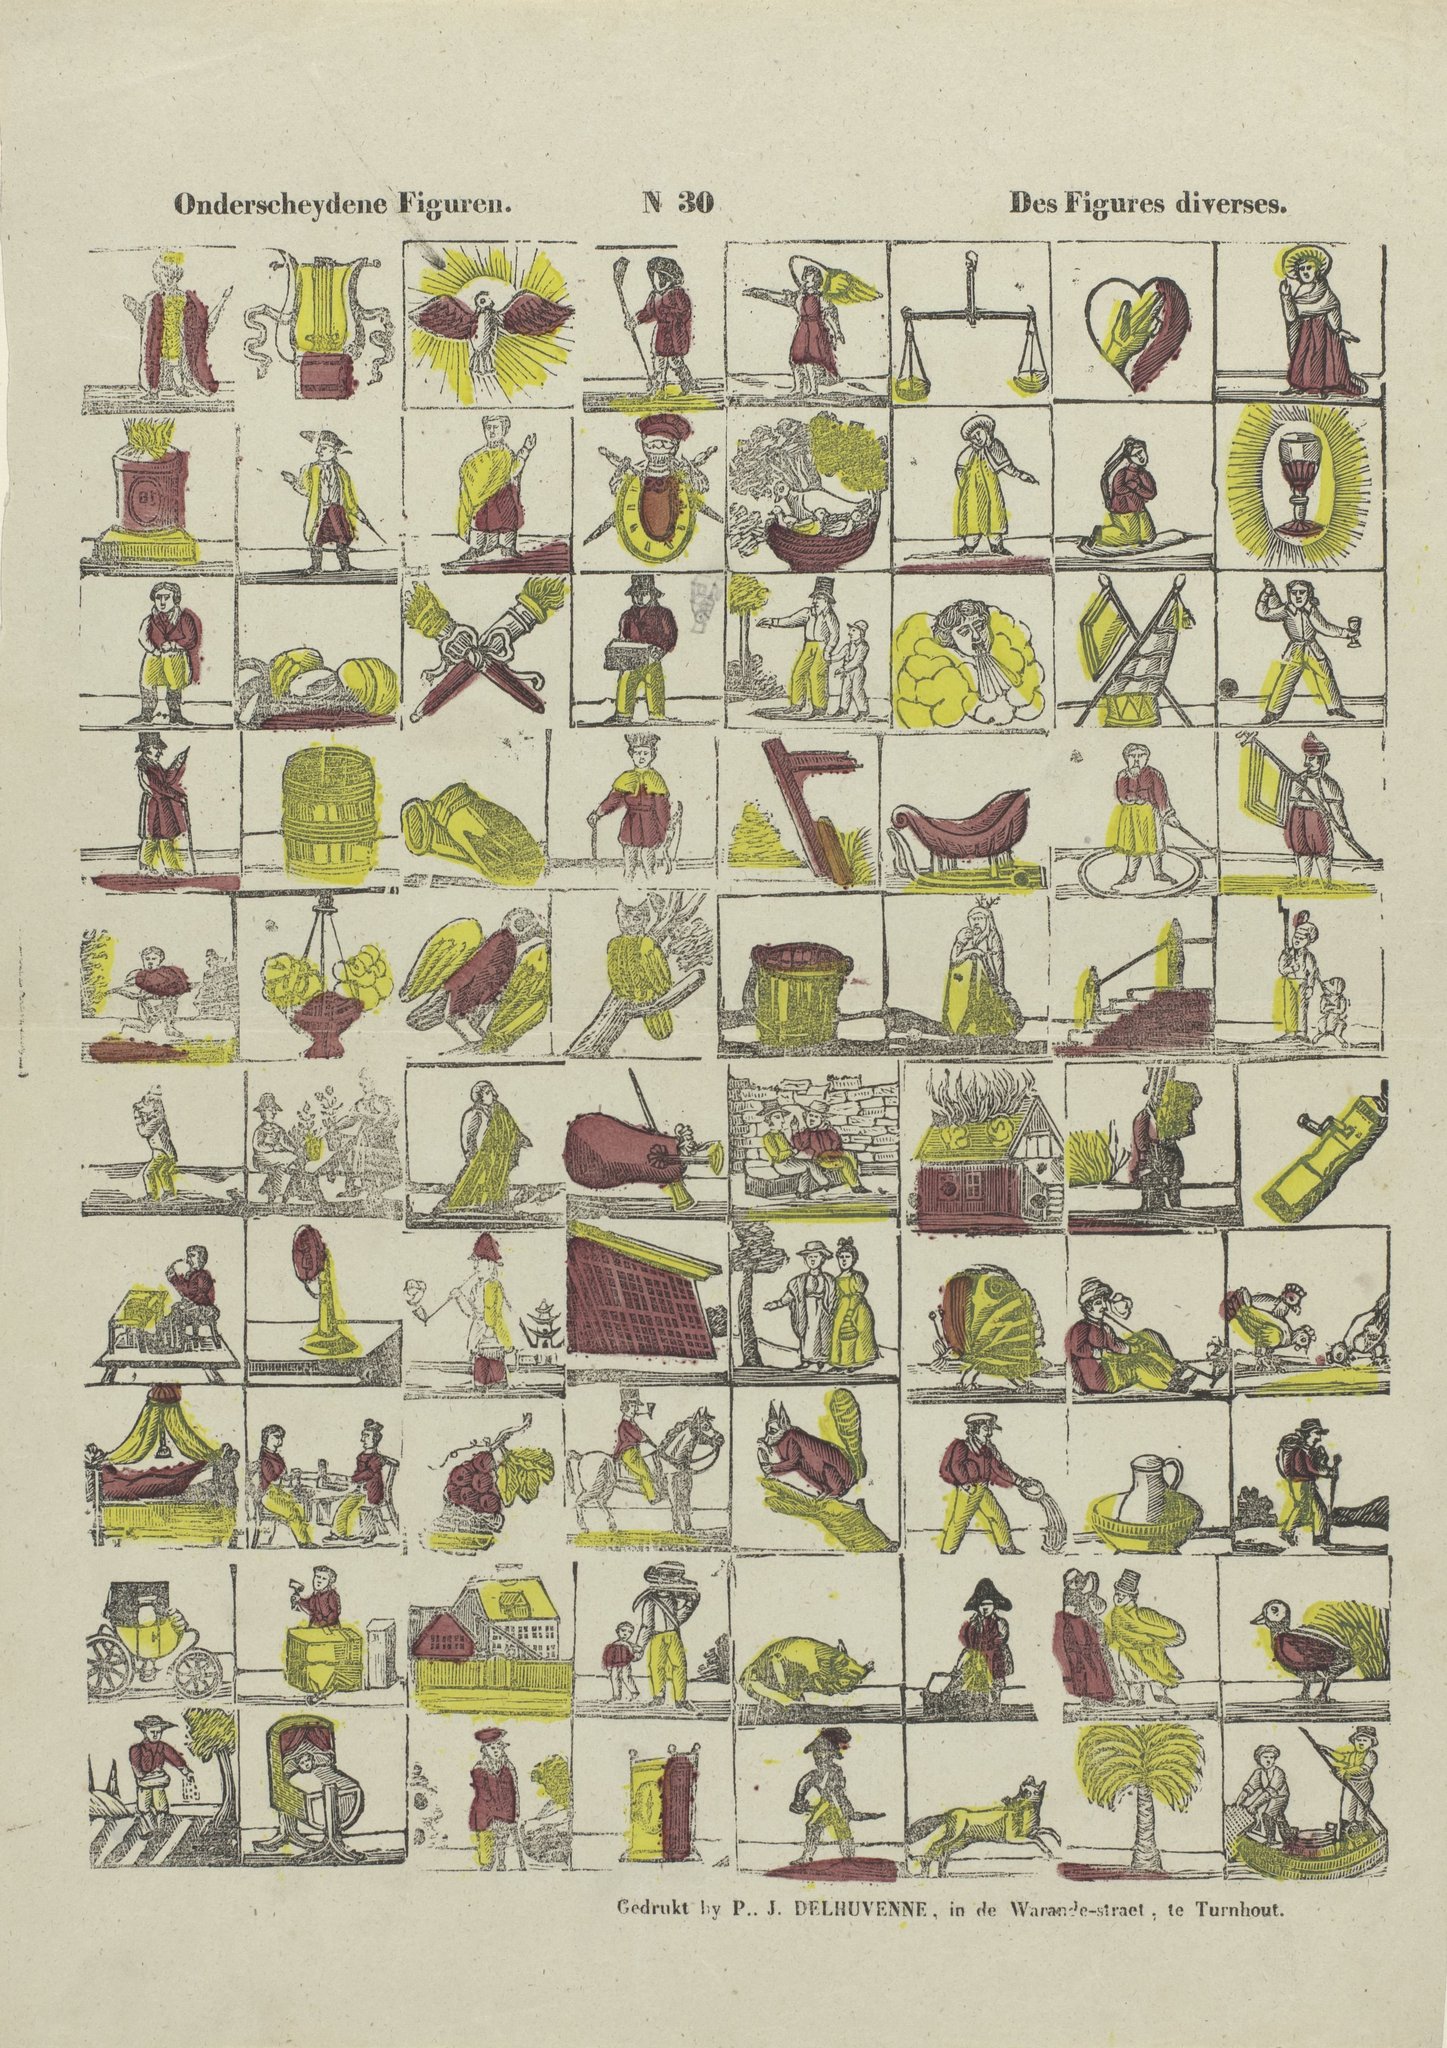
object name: print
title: Zwitsersche gezigten. / Vues Suisses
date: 1842-1856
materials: paper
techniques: colour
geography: turnhout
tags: furniture for babies, animals, other objects ~ the church (not necessarily liturgical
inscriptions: collector's mark: Lugt 2760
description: Blad met 80 voorstellingen van allerlei voorwerpen en figuren waaronder een slee, een personificatie van de wind, een eekhoorn en een baby in een wieg. Genummerd midden boven: N 30.